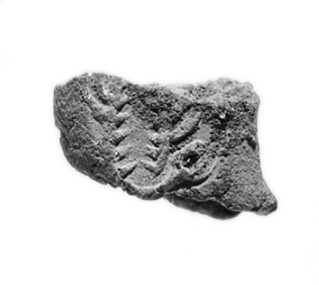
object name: sealing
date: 1981-1640 BCE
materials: mud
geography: egypt